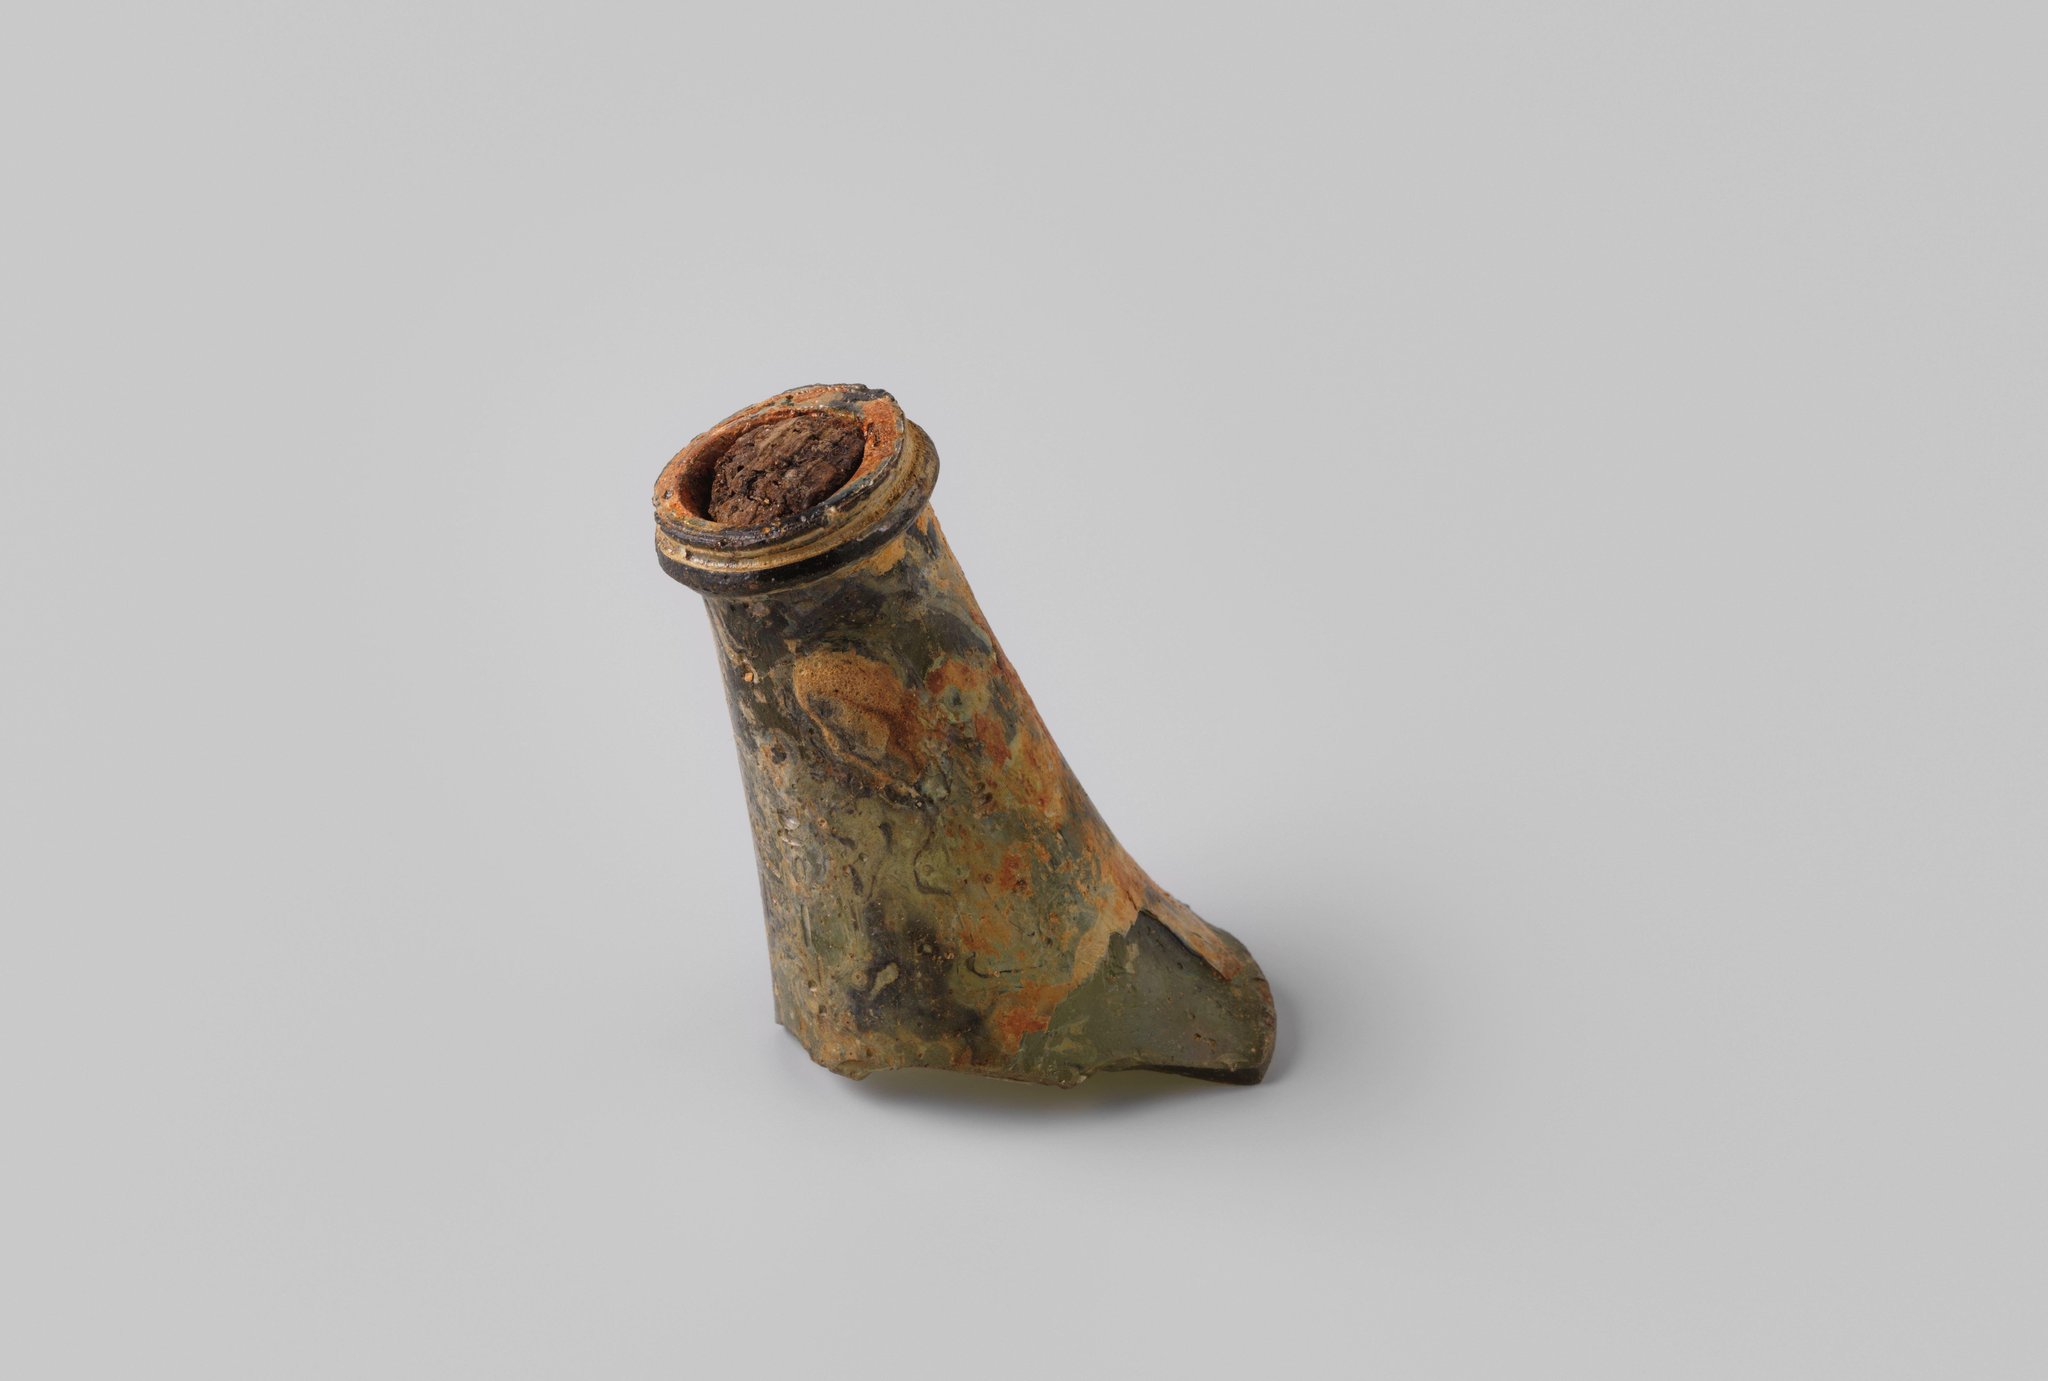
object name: neck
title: Hals met kurk van een wijnfles uit het wrak van de Oost-Indiëvaarder Hollandia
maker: Anonymous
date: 1700-1743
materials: cork, glass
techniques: green glass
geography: netherlands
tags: verenigde oostindische compagnie, hollandia (schip), annet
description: Wine bottle, continental production, neck, onion-shaped bottle or bottle with vertical side; eroded, narrow vs-string rim, cork level with mouth